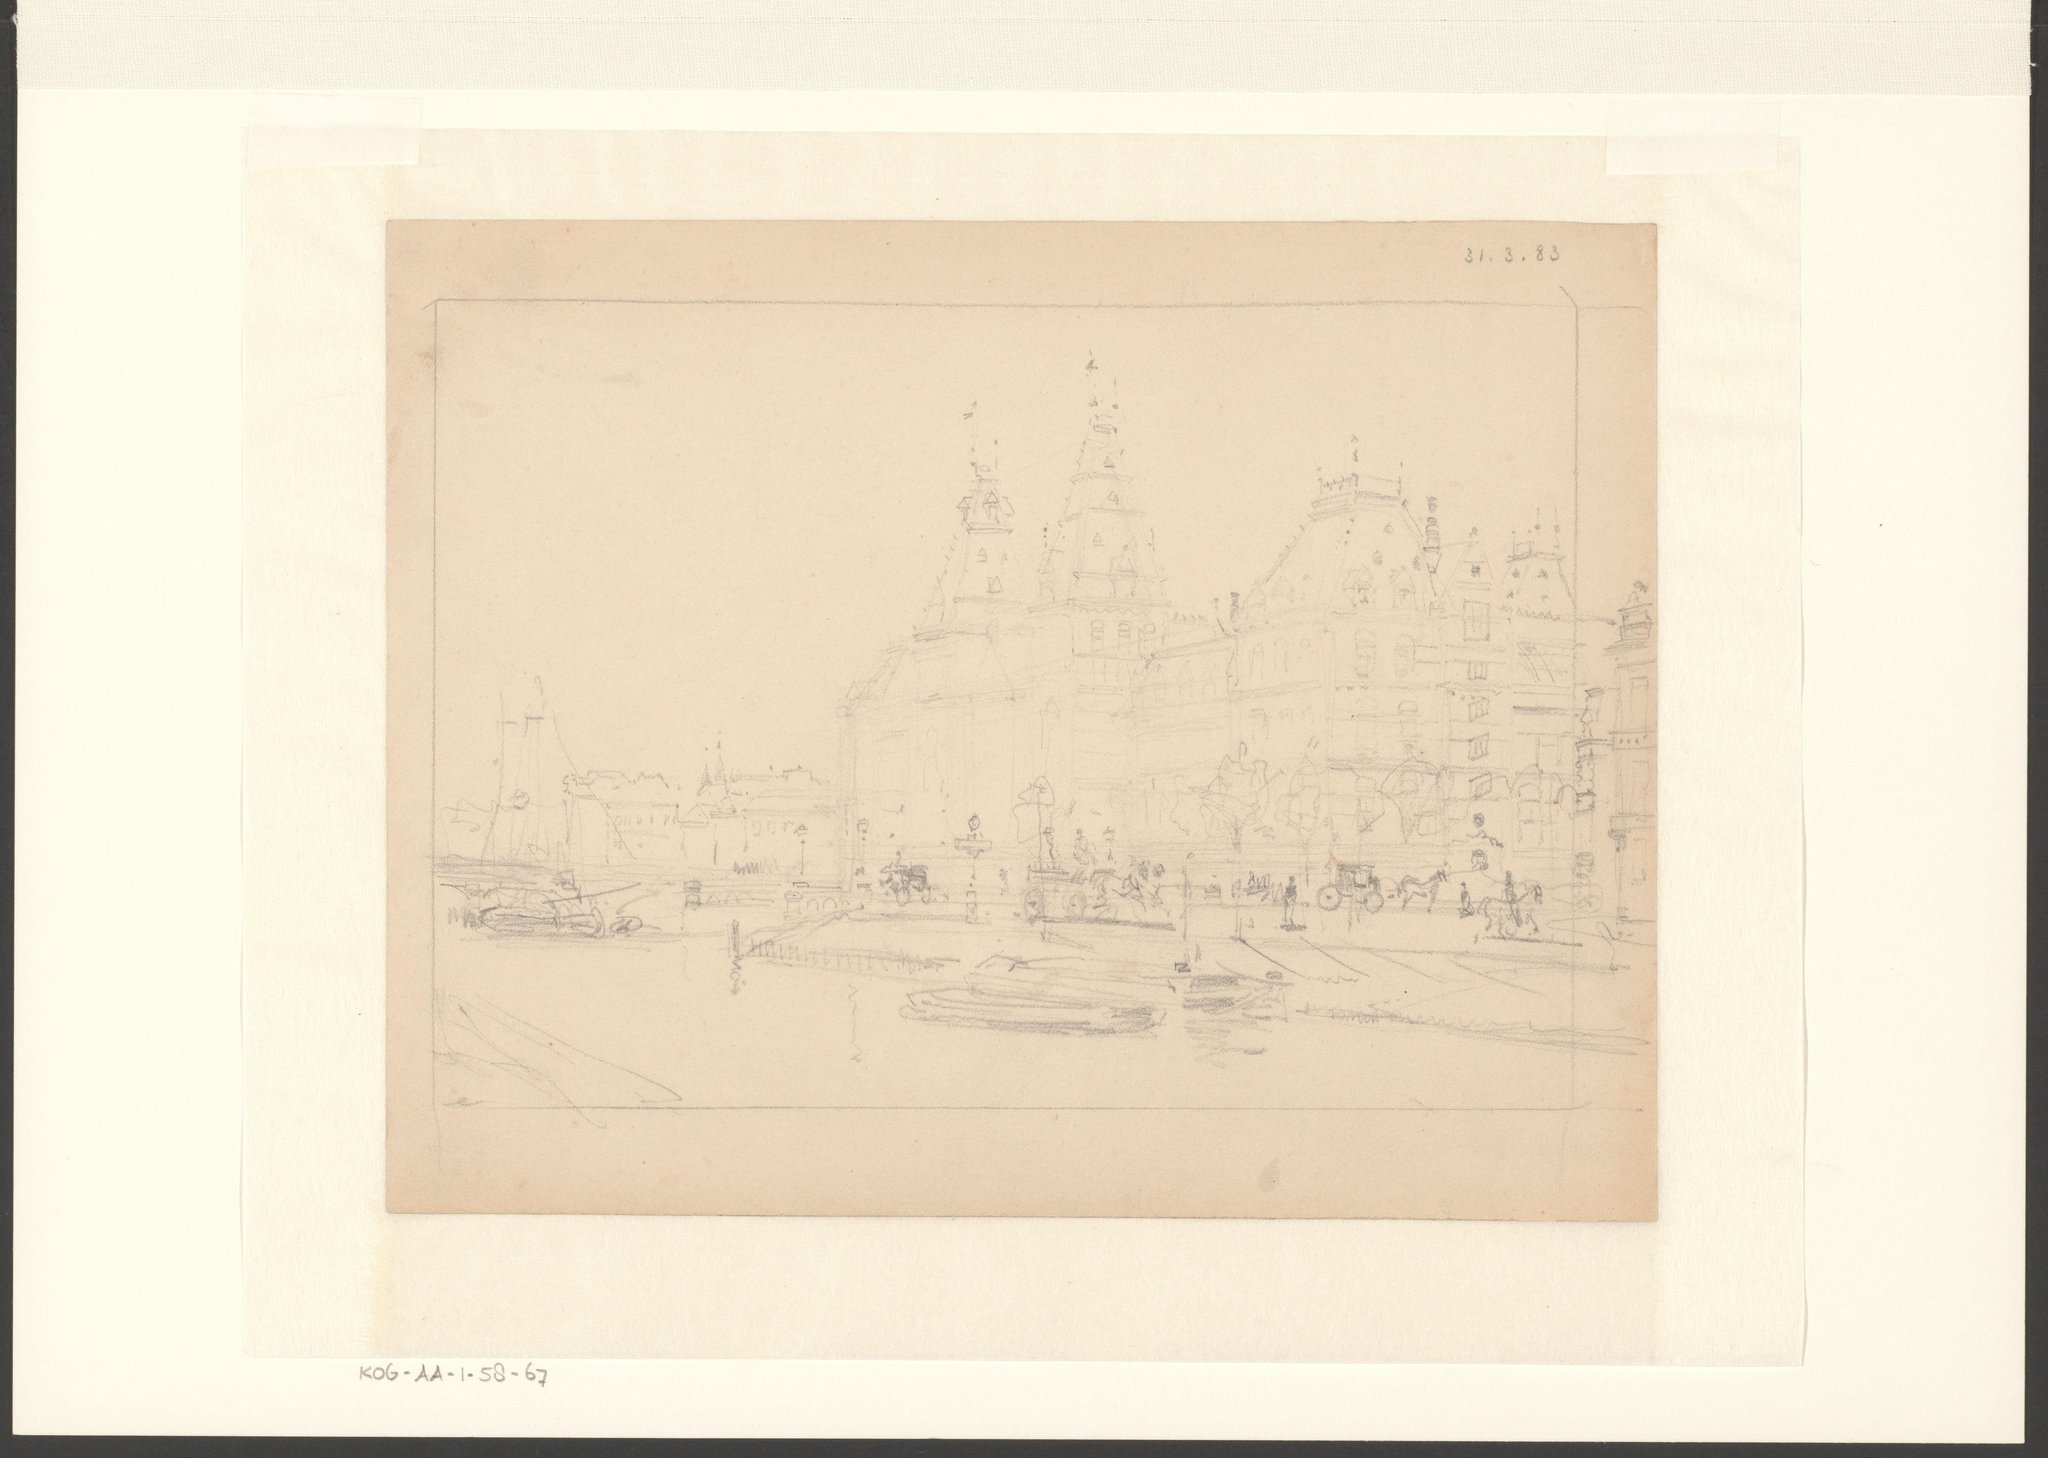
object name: drawing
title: Gezicht op het Rijksmuseum van over het Singel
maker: johan conrad greive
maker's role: draughtsman, painter, print maker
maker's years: 1837-1891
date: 1883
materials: paper, pencil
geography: amsterdam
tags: city-view in general; 'veduta', canal, permanent exhibition, museum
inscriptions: date: ‘31.3.83’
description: Onderwerpsrubriek binnen de Atlas Amsterdam: Rijksmuseum.